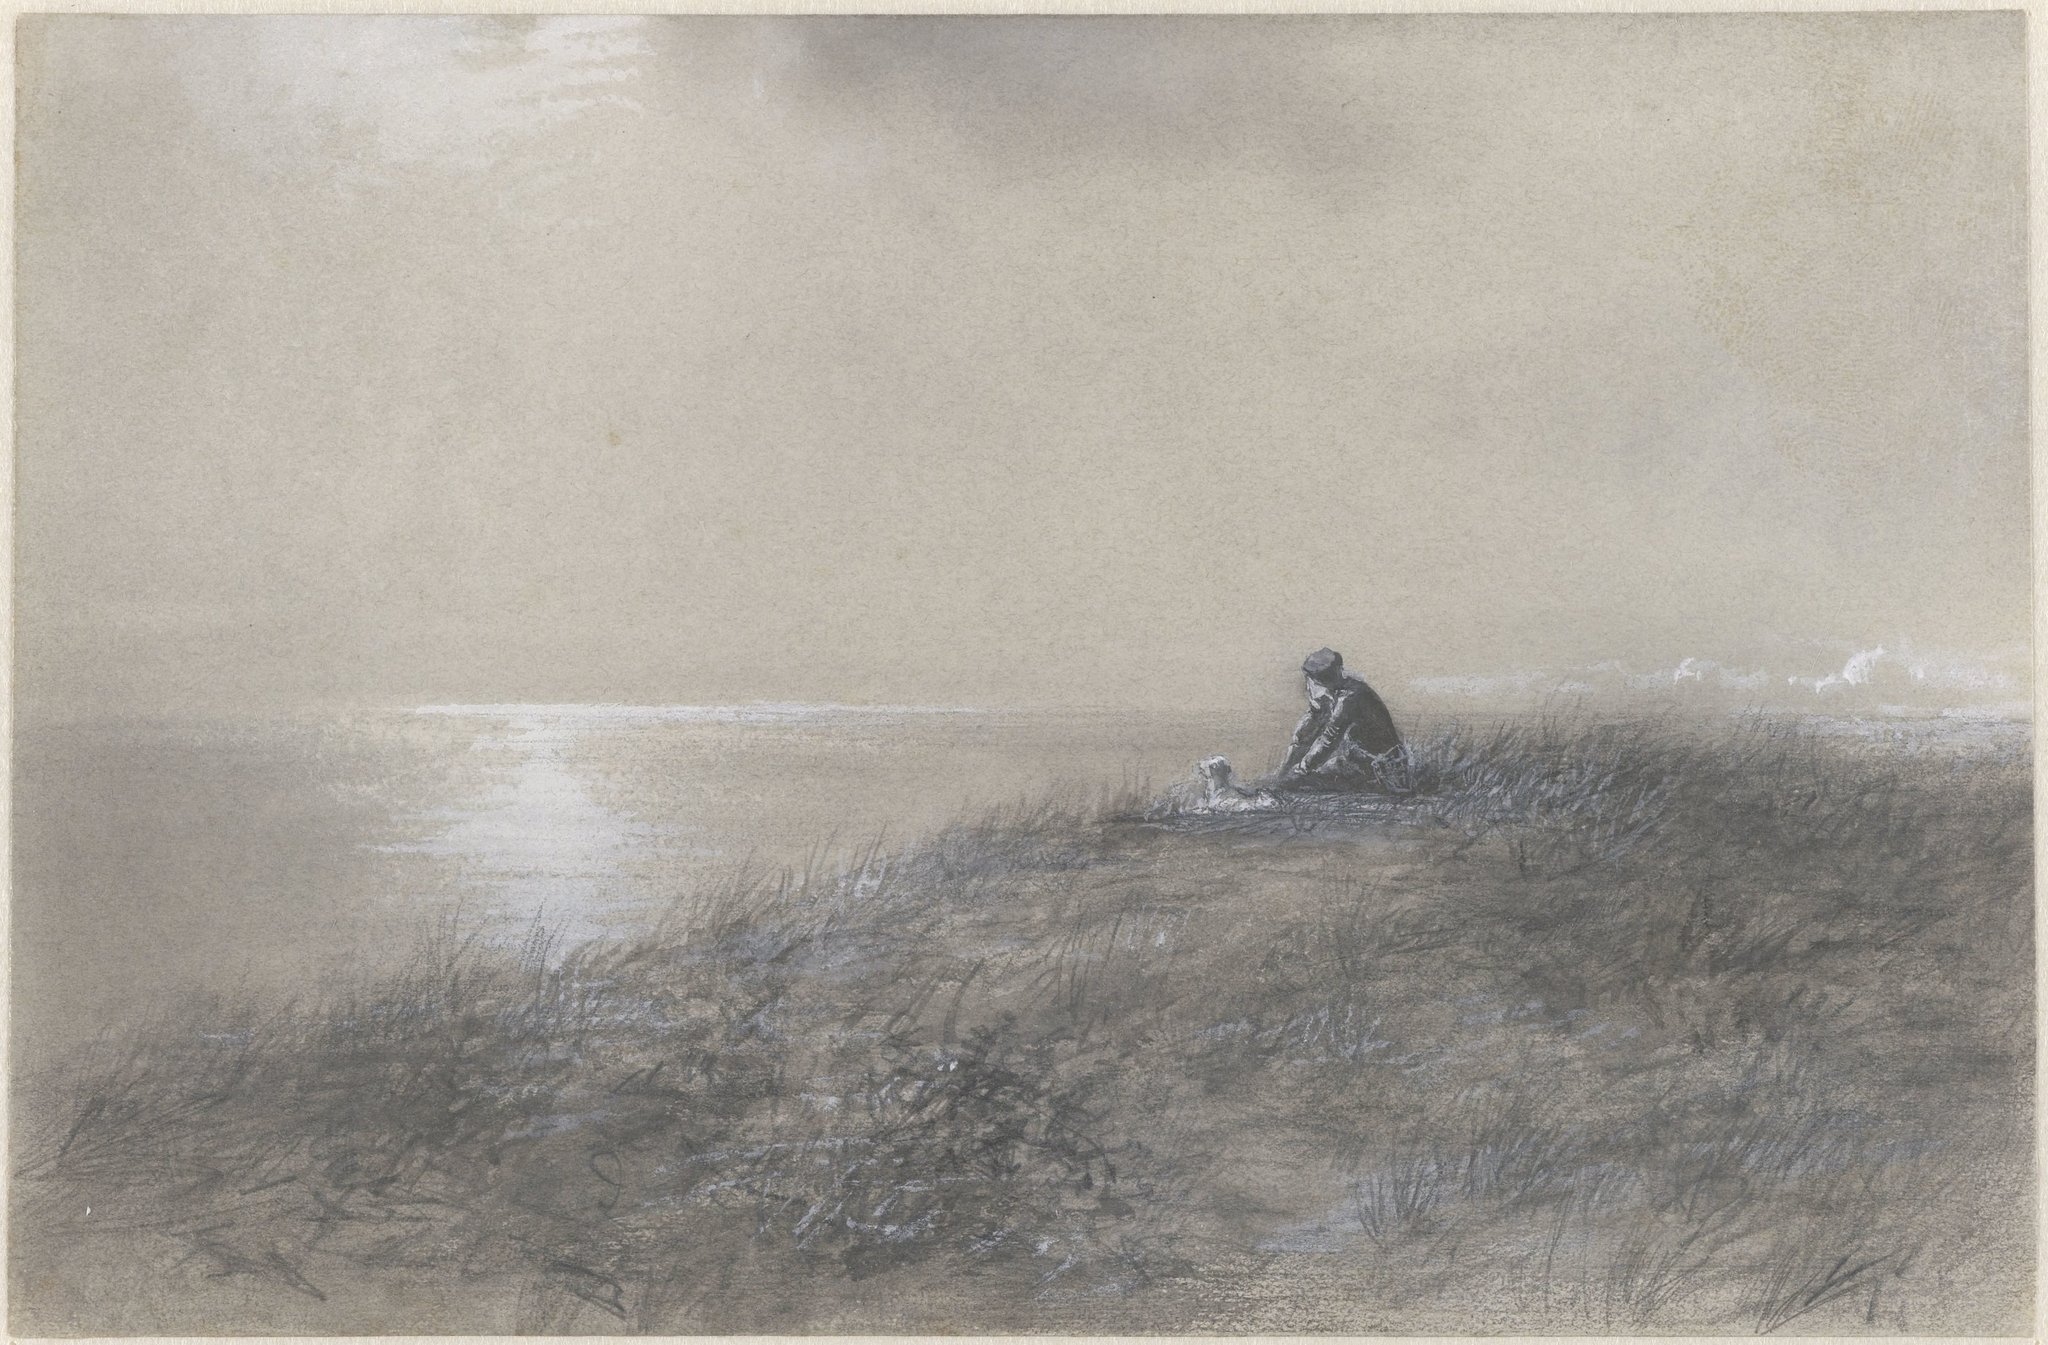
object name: design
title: Teun de jager met hond in de duinen uitkijkend over de zee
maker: ferdinand carl sierich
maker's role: draughtsman, painter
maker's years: 1839-1905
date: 1849-1905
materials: paper, pencil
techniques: brush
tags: sitting figure, hunter, dunes (sea not visible); in the dunes, dog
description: Voorstudie voor houtgravure in Camera Obscura (Haarlem, 1878?) van Hildebrand.